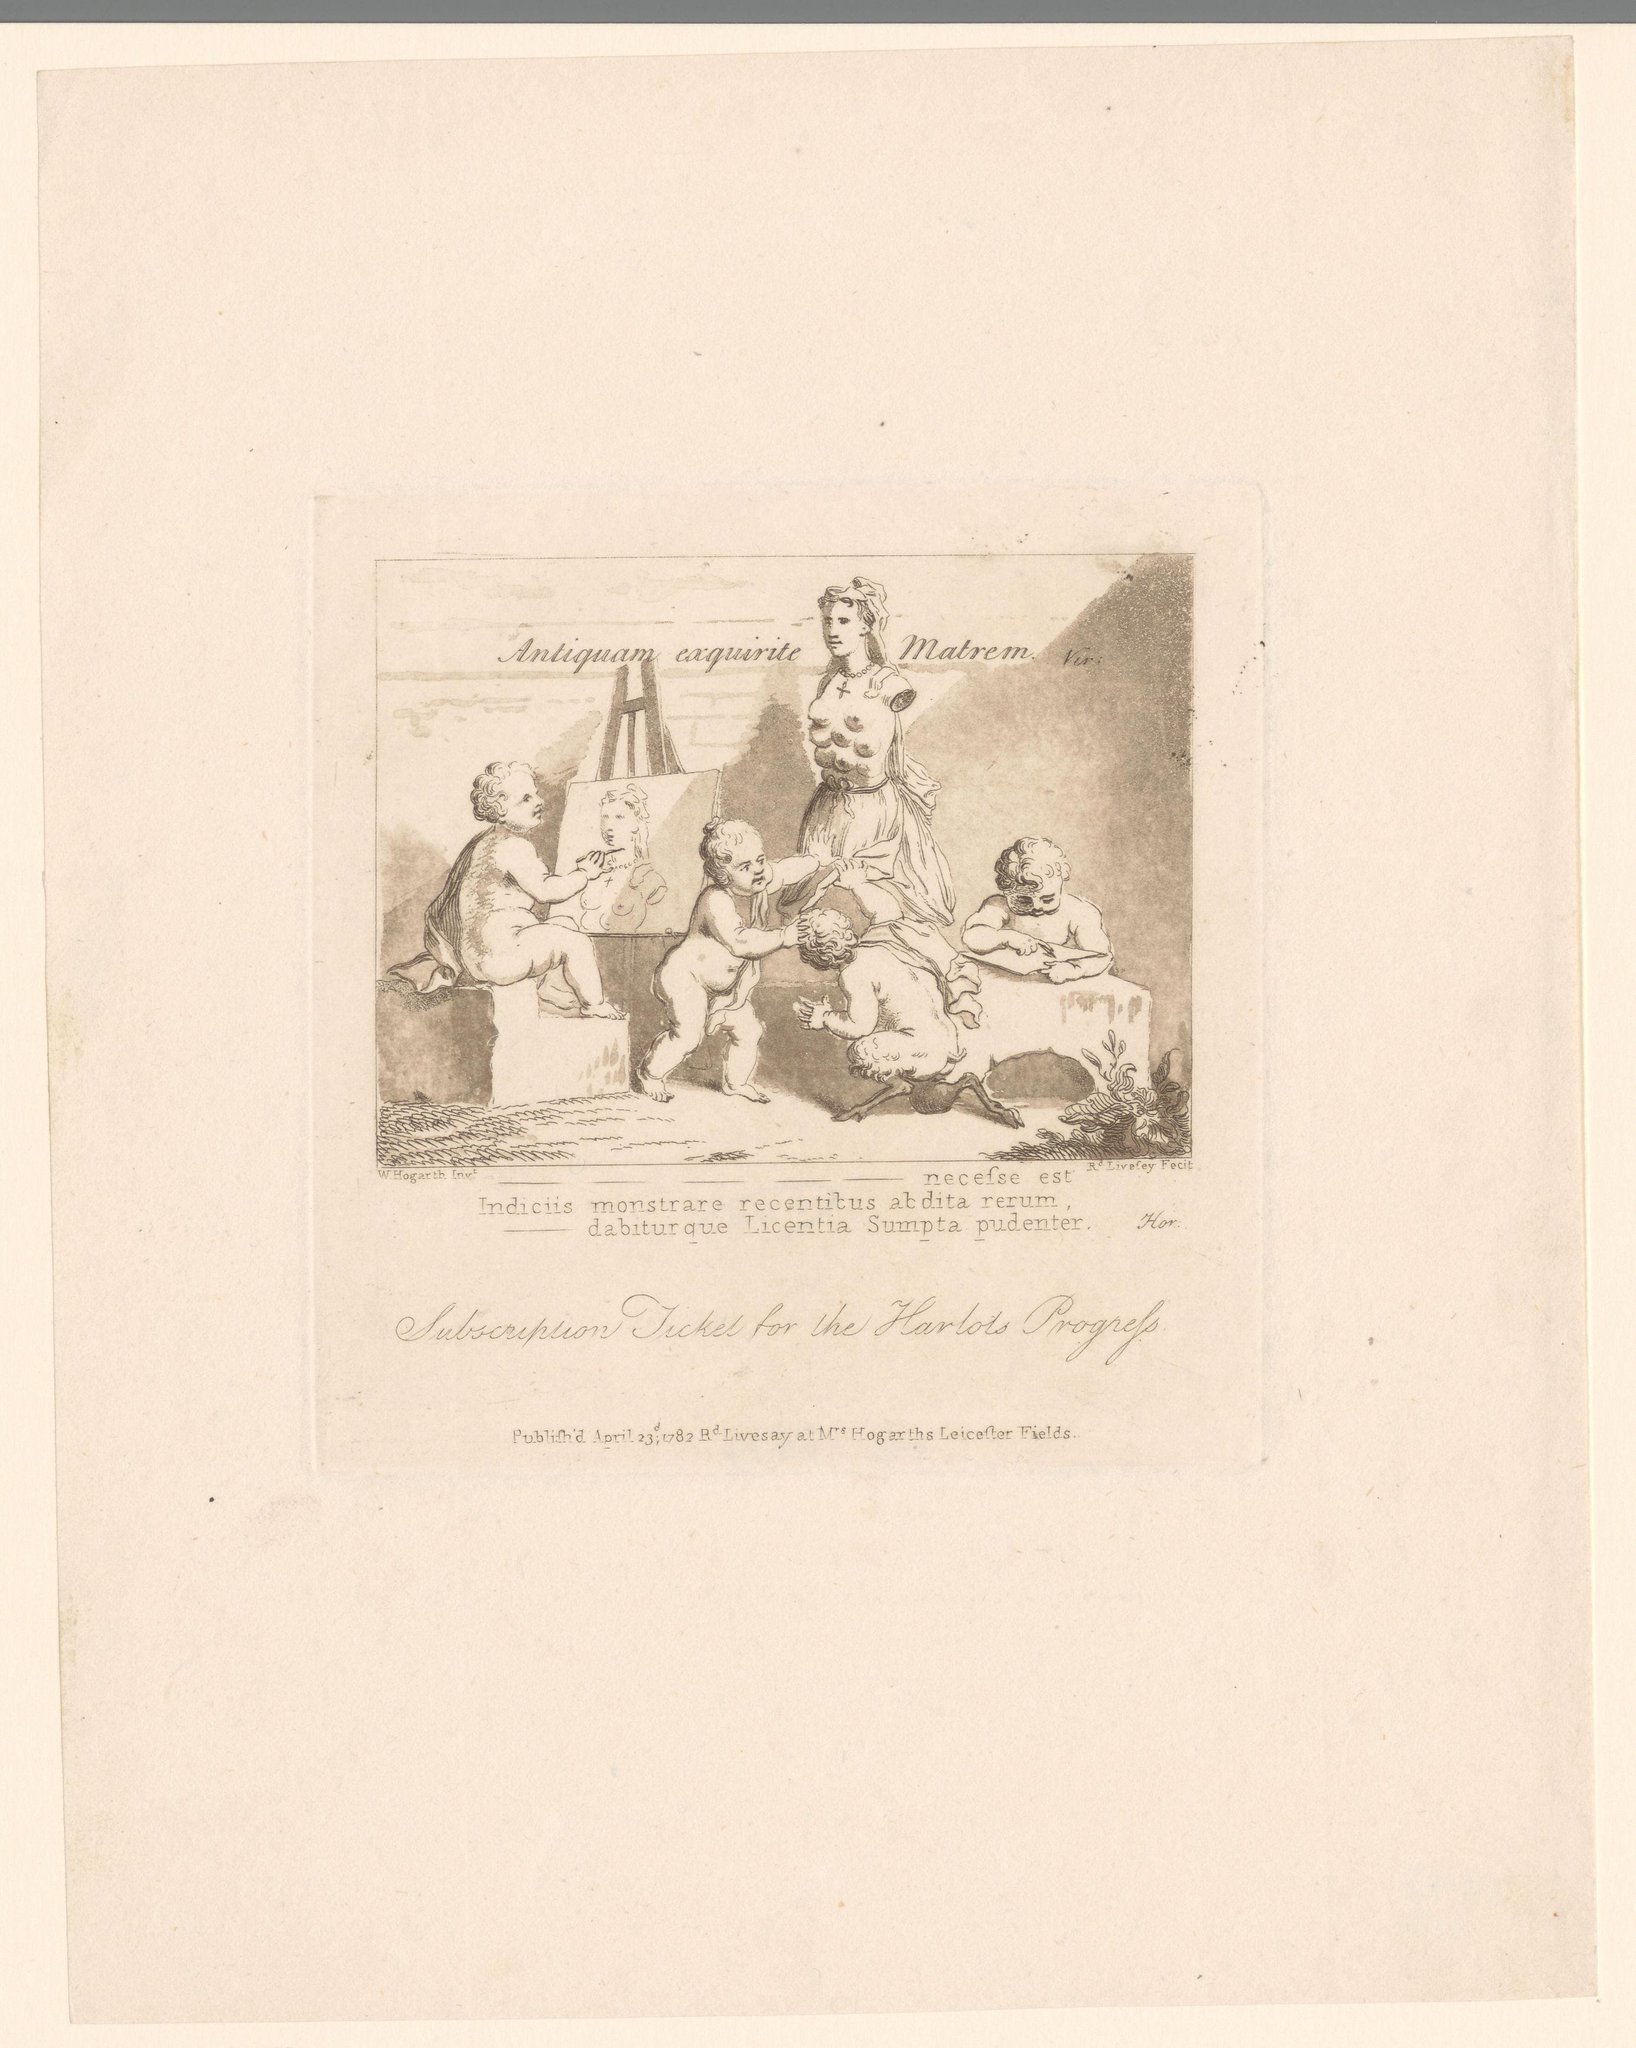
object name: print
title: Antiguam exquirite Matrem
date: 1782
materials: paper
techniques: aquatint, etching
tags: draughtsman at work, motherhood, cupids: 'amores', 'amoretti', 'putti'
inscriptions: collector's mark: Lugt 2228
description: De originele prent door Hogarth is waarschijnlijk oorspronkelijk bedoeld als aankoopbewijs (subscription ticket) voor prenten uit de serie 'The Harlots Progress'.